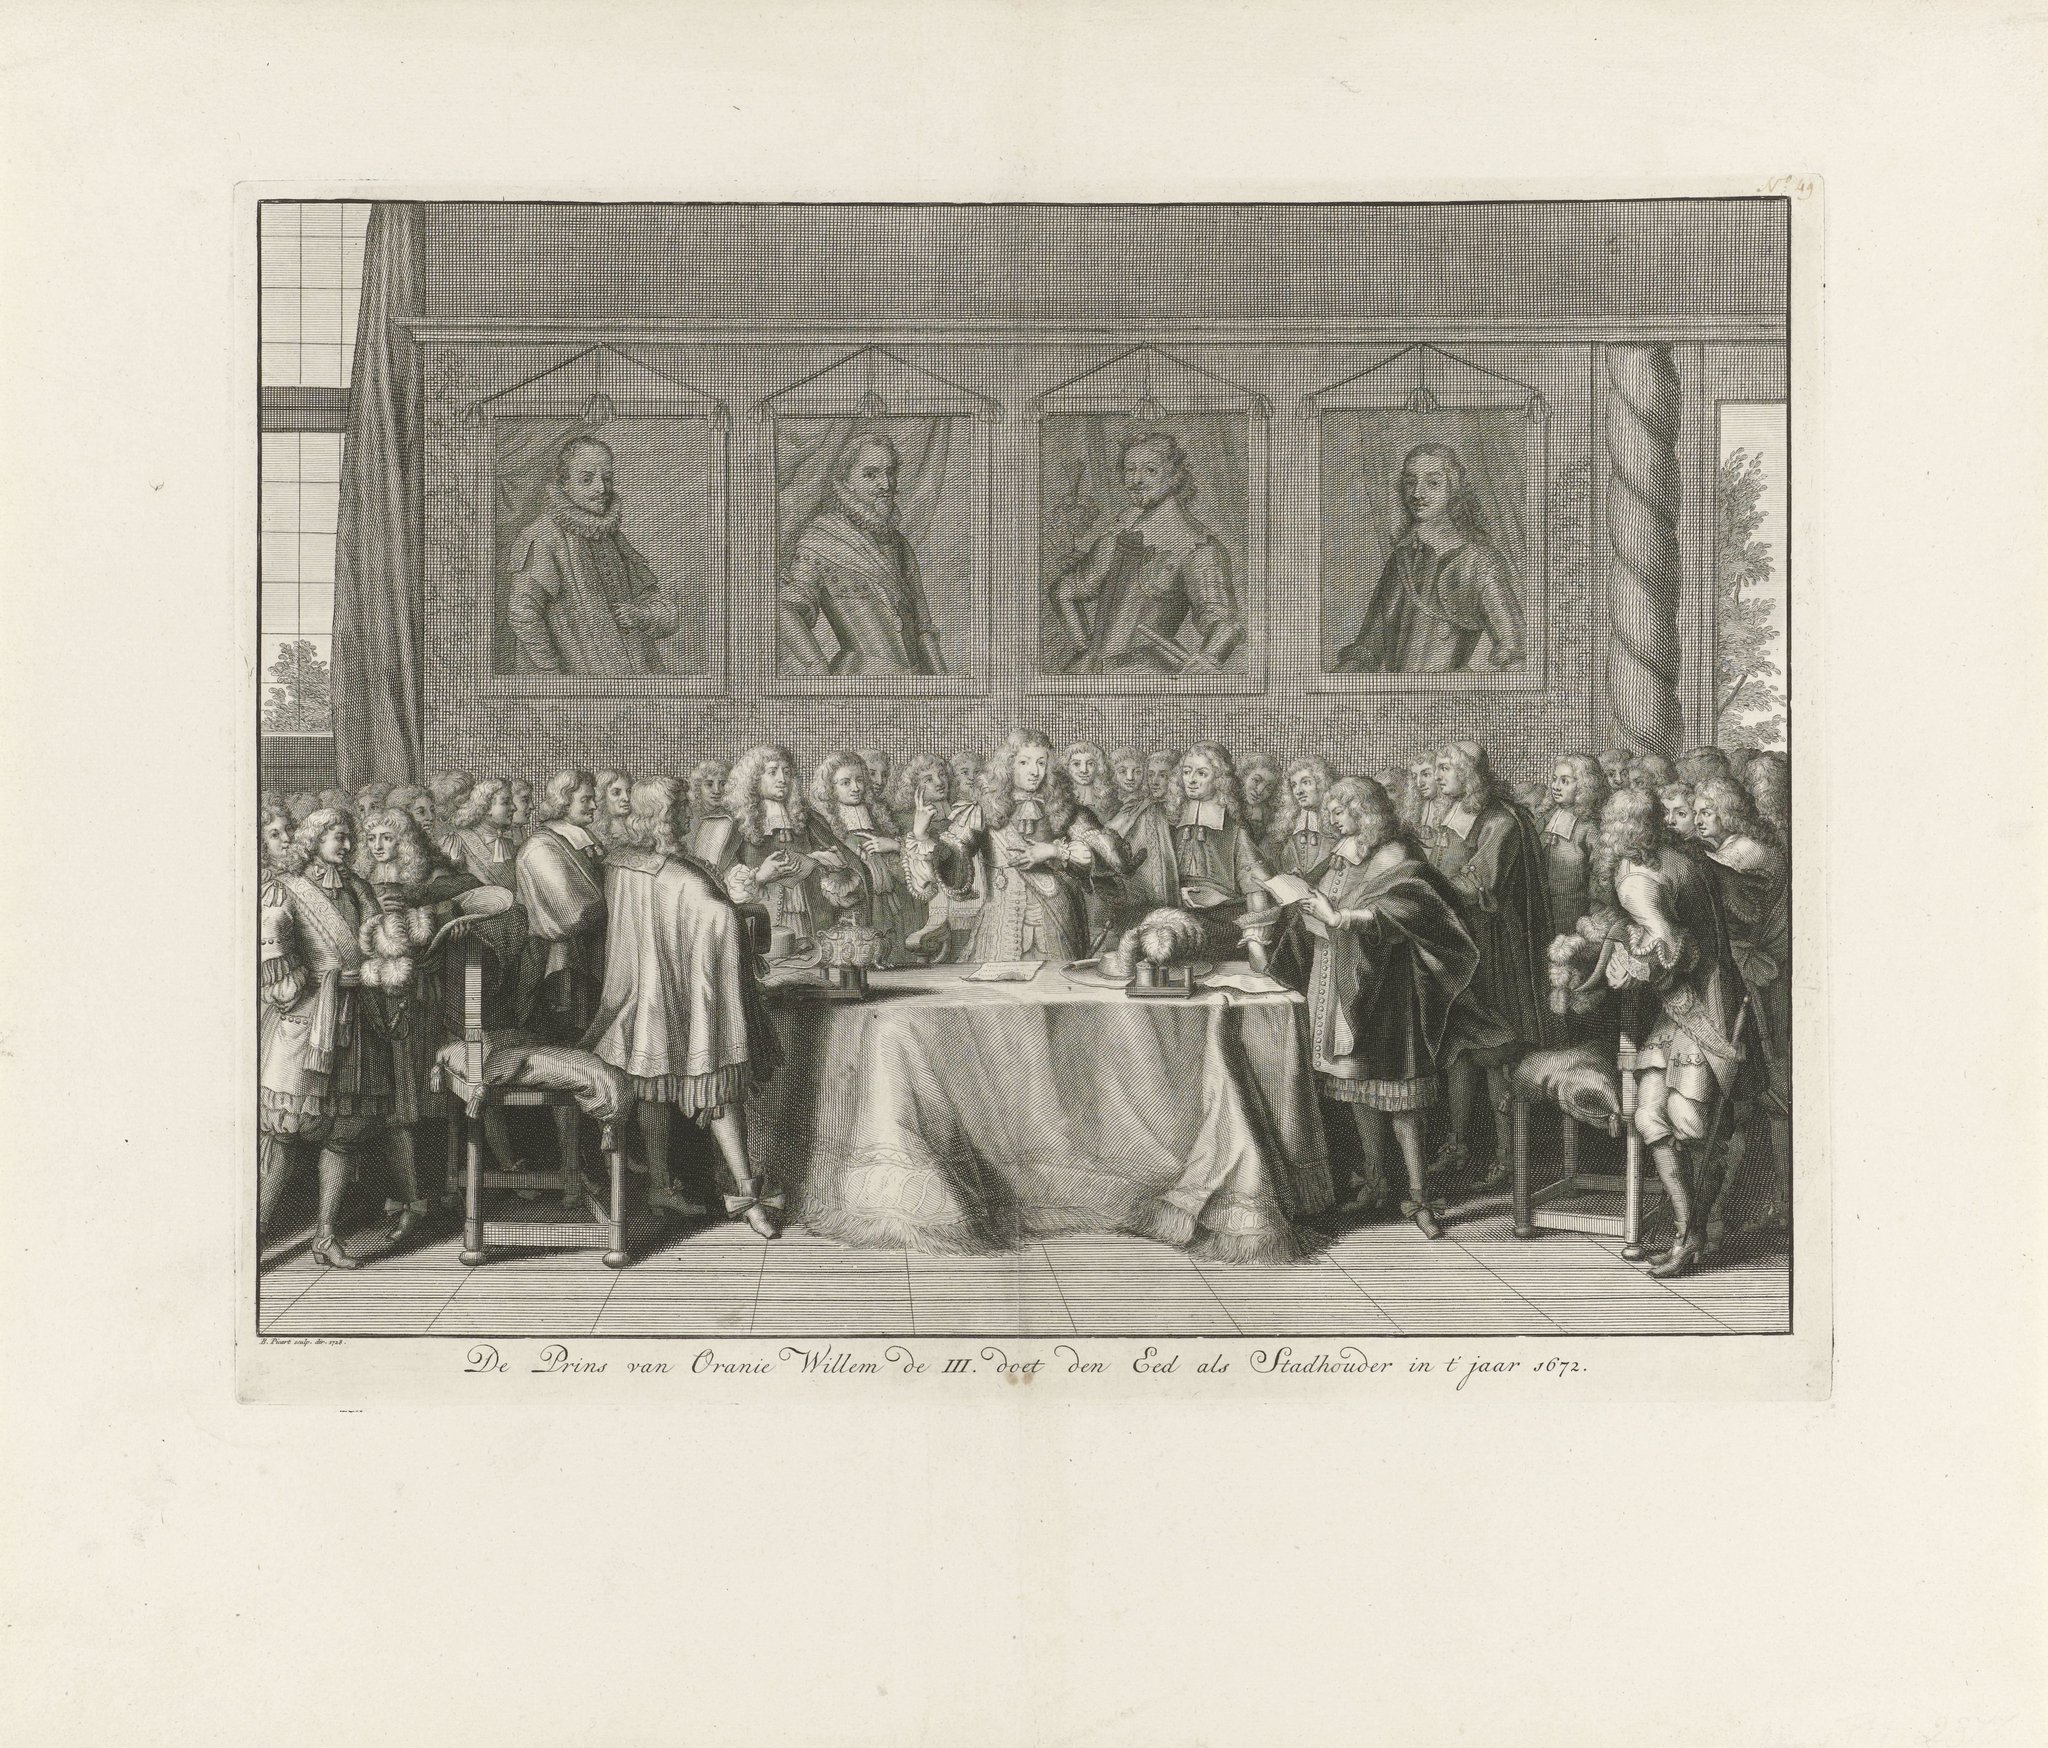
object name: print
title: Willem III wordt ingezworen als stadhouder, 1672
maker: bernard picart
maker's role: draughtsman, print maker, publisher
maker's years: 1673-1733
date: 1728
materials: paper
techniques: engraving, etching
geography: amsterdam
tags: the hague, william iii (prince of orange and king of england, scotland, and ireland), frederick henry (prince of orange), william ii (prince of orange), delft, william i (prince of orange), maurice (prince of orange), new ruler taking the oath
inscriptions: number: ‘N. 49’, collector's mark: Lugt 2228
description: Prent ook gebruikt als illustratie in: Clerc, J. le. Geschiedenissen der Vereenigde Nederlanden, sedert den aanvang van die Republyk tot op den Vrede van Utrecht in 't jaar 1713 en het Tractaat van Barriere in 't jaar 1715 gesloten, deel III, p. 410. Amsterdam: Zacharias Chatelain (II), 1730.